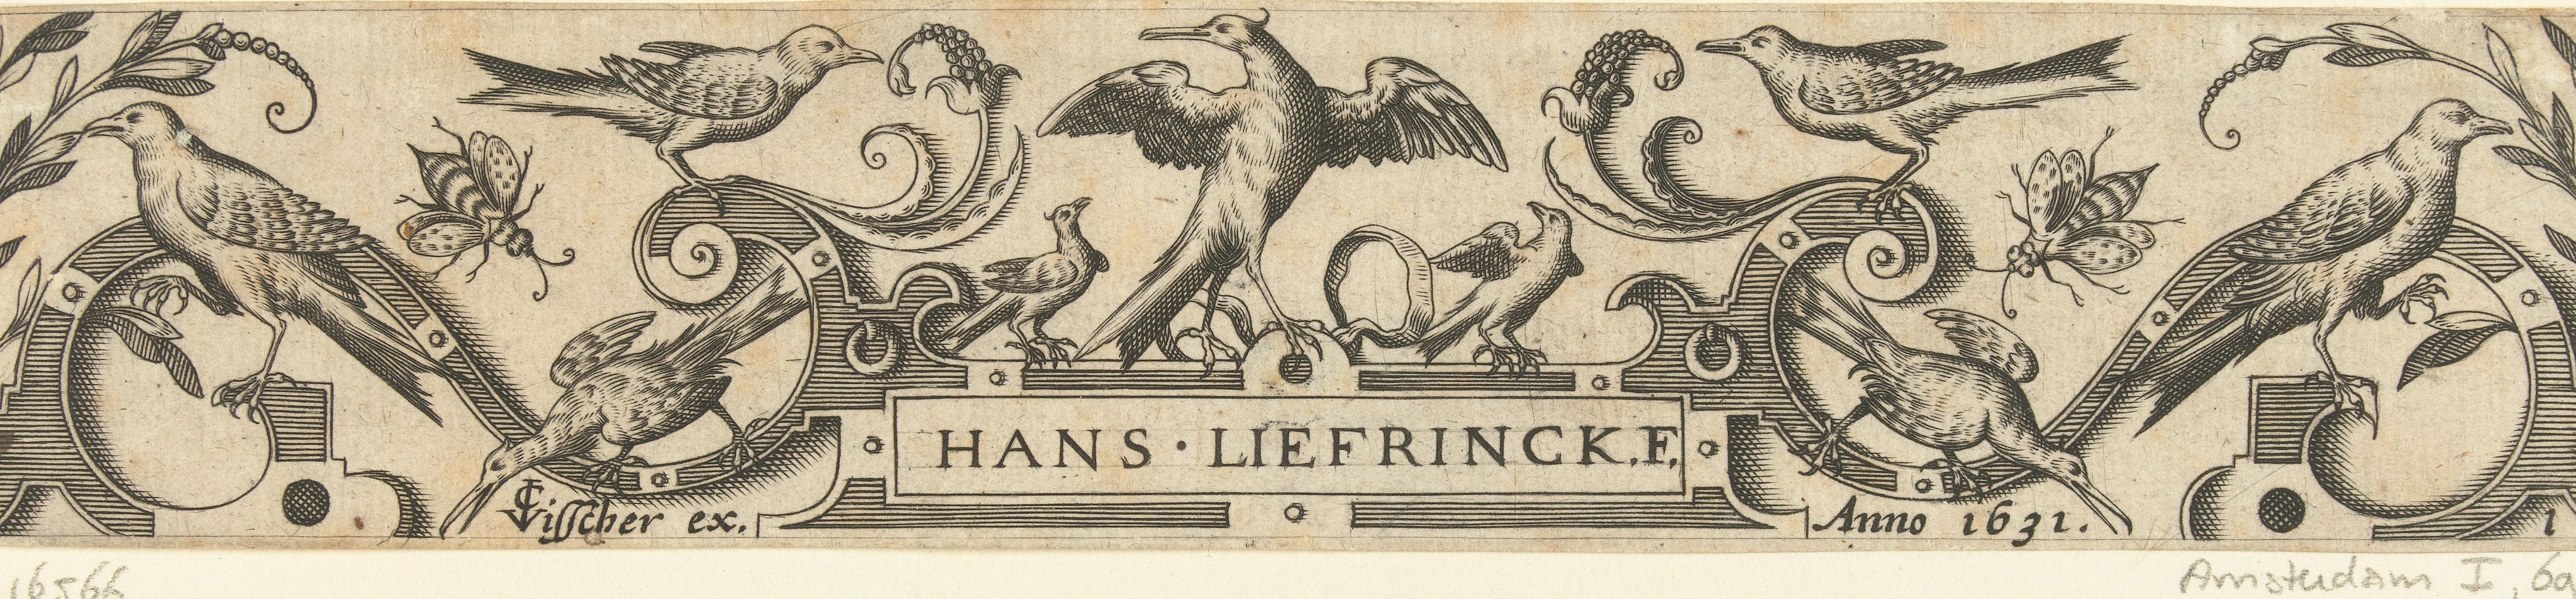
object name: ornament print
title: Titelblad met diverse vogels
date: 1631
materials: paper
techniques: engraving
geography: netherlands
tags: birds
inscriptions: date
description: Cartouche met de naam HANS LIEFRINCK.F.middenonder tussen voluten van beslagwerk. Op het beslagwerk staan diverse vogels. Blad 1 uit serie van 12 genummerde bladen.